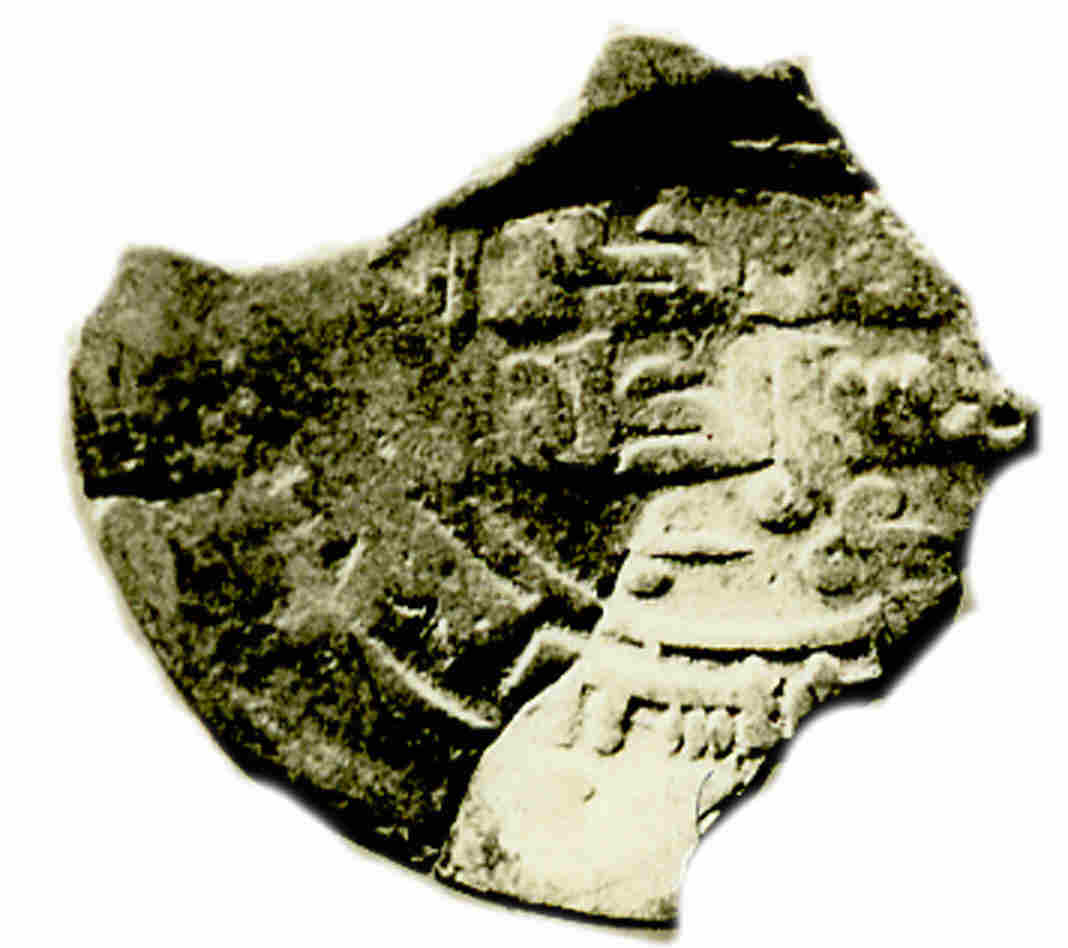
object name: coin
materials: silver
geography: iran